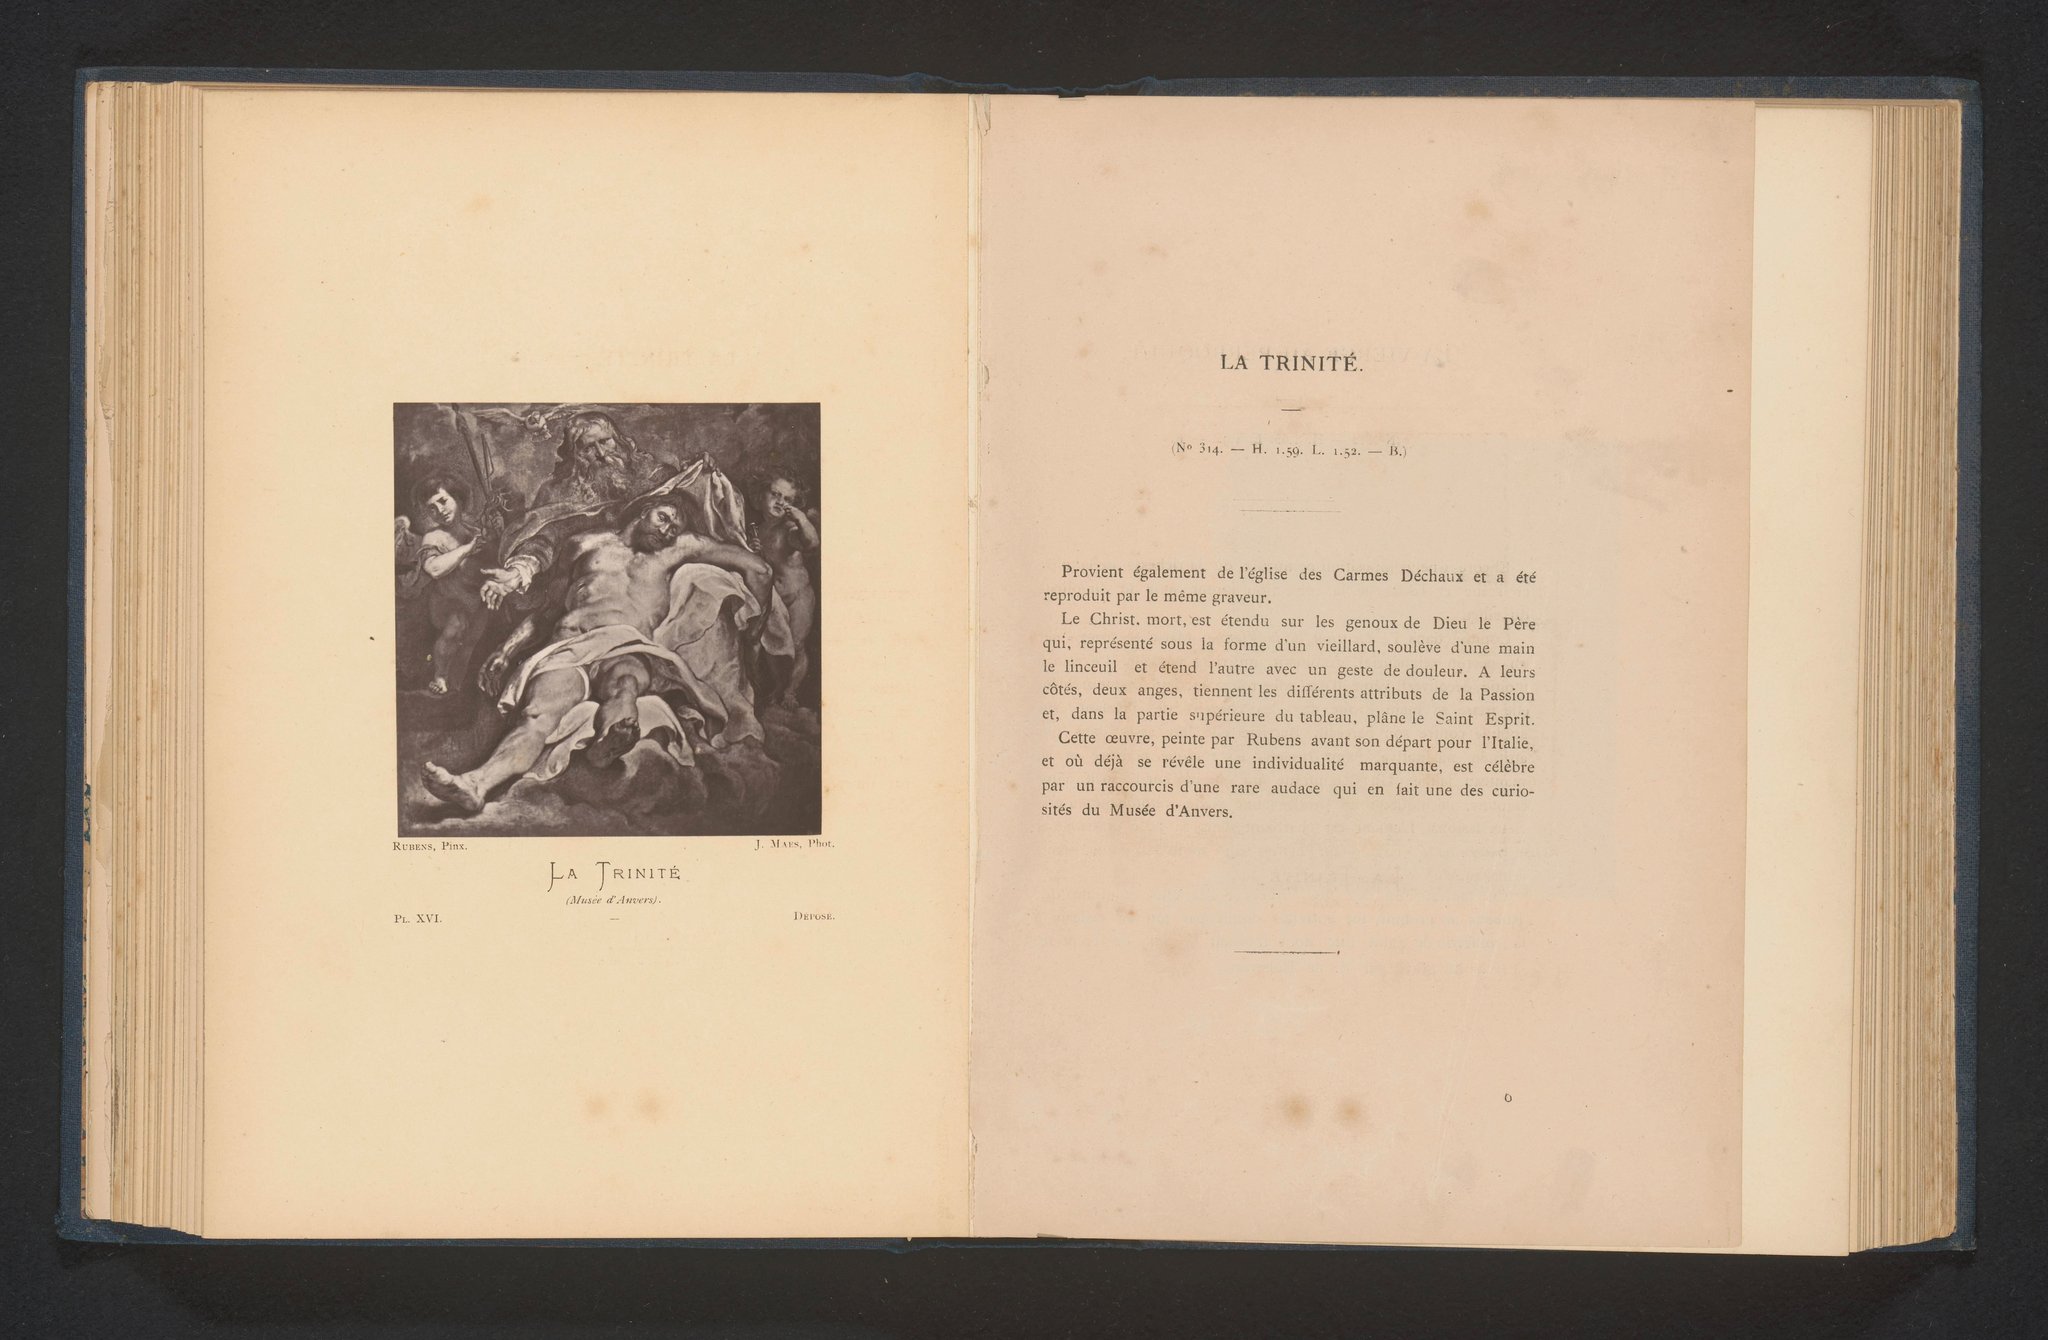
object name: photomechanical print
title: La Trinité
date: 1872-1877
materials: paper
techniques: woodburytype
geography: antwerp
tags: god the father holding the crucified or dead christ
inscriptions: inscription: ‘(Musée d'Anvers)/ Pl. XVI. Déposé.’